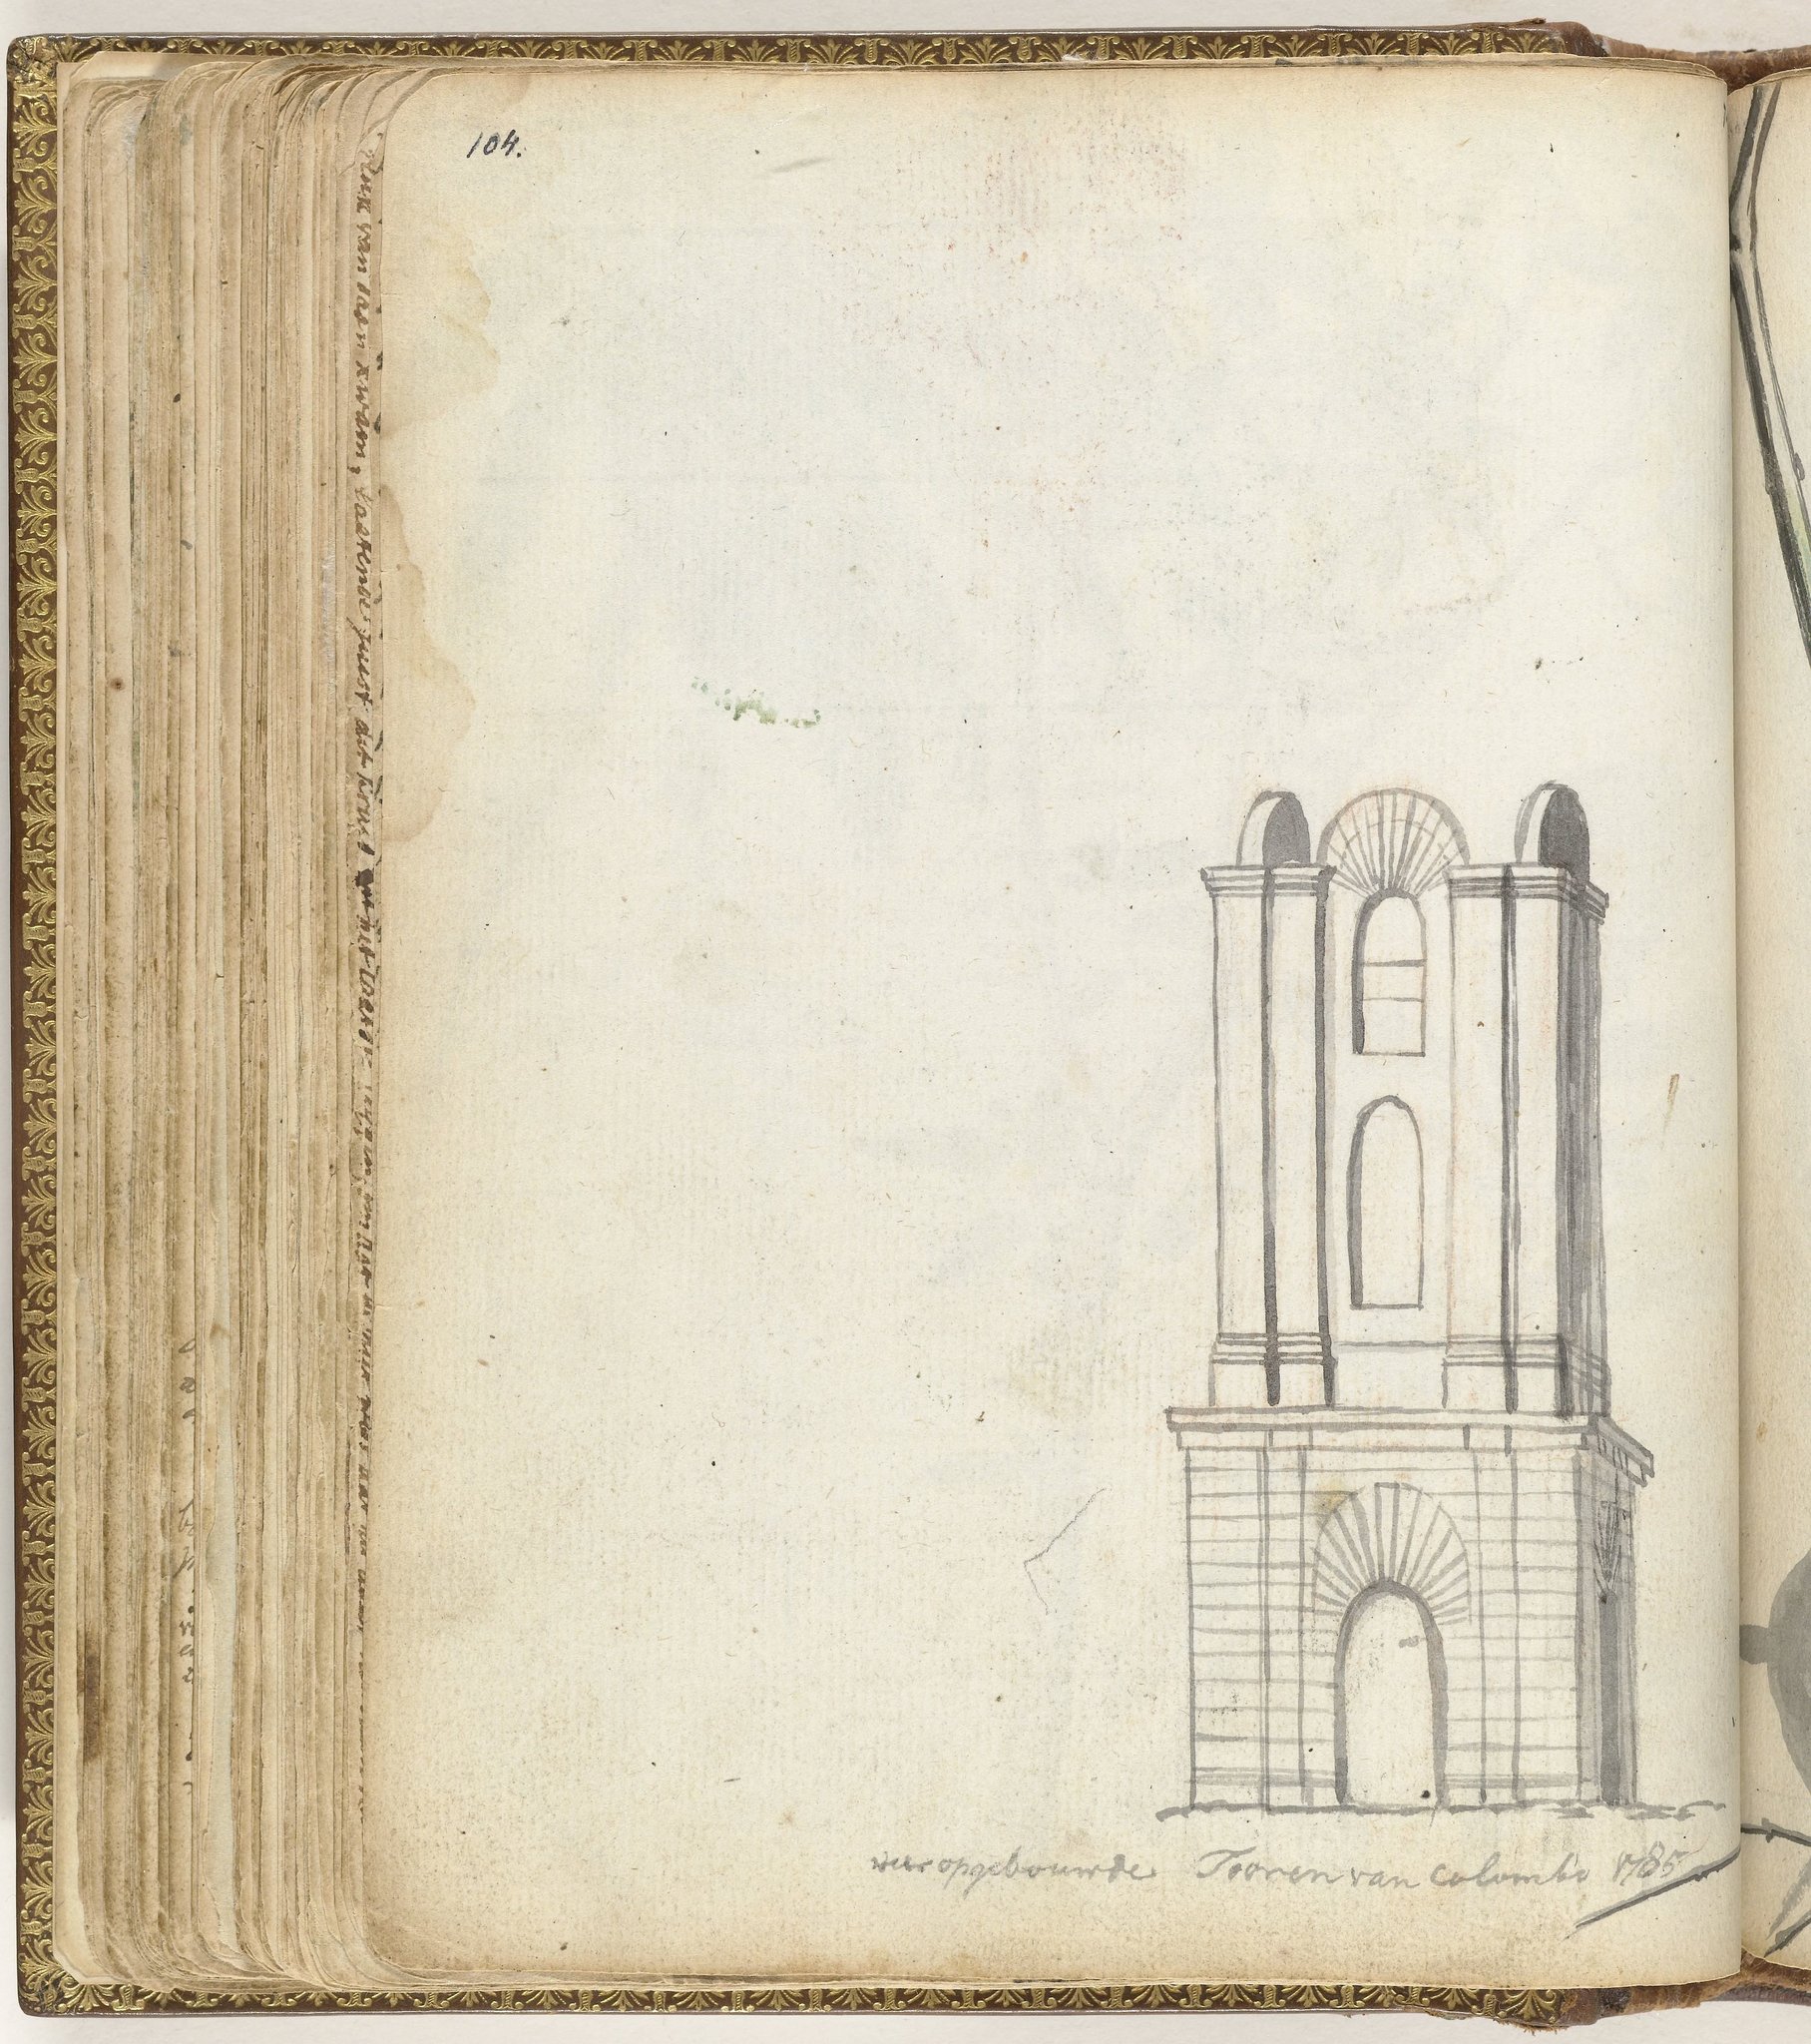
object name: drawing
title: De toren van Colombo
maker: jan brandes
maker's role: draughtsman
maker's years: 1743-1808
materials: paper, pencil, watercolor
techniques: brush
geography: colombo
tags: tower (of house or building)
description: Kleurtekening van de 'weer opgebouwde' toren van Colombo. Met opschrift. Onderdeel uit het schetsboek van Jan Brandes, dl. 1 (1808), p. 104.